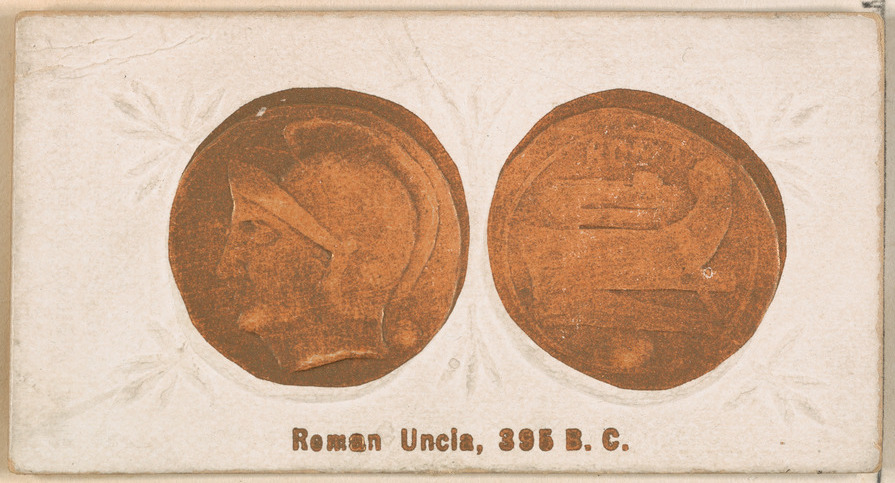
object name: print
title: Roman Uncla, 395 B.C., from the Ancient Coins series (N180) issued by Wm. S. Kimball & Co.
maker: william s. kimball & company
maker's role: publisher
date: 1888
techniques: color lithograph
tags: coins